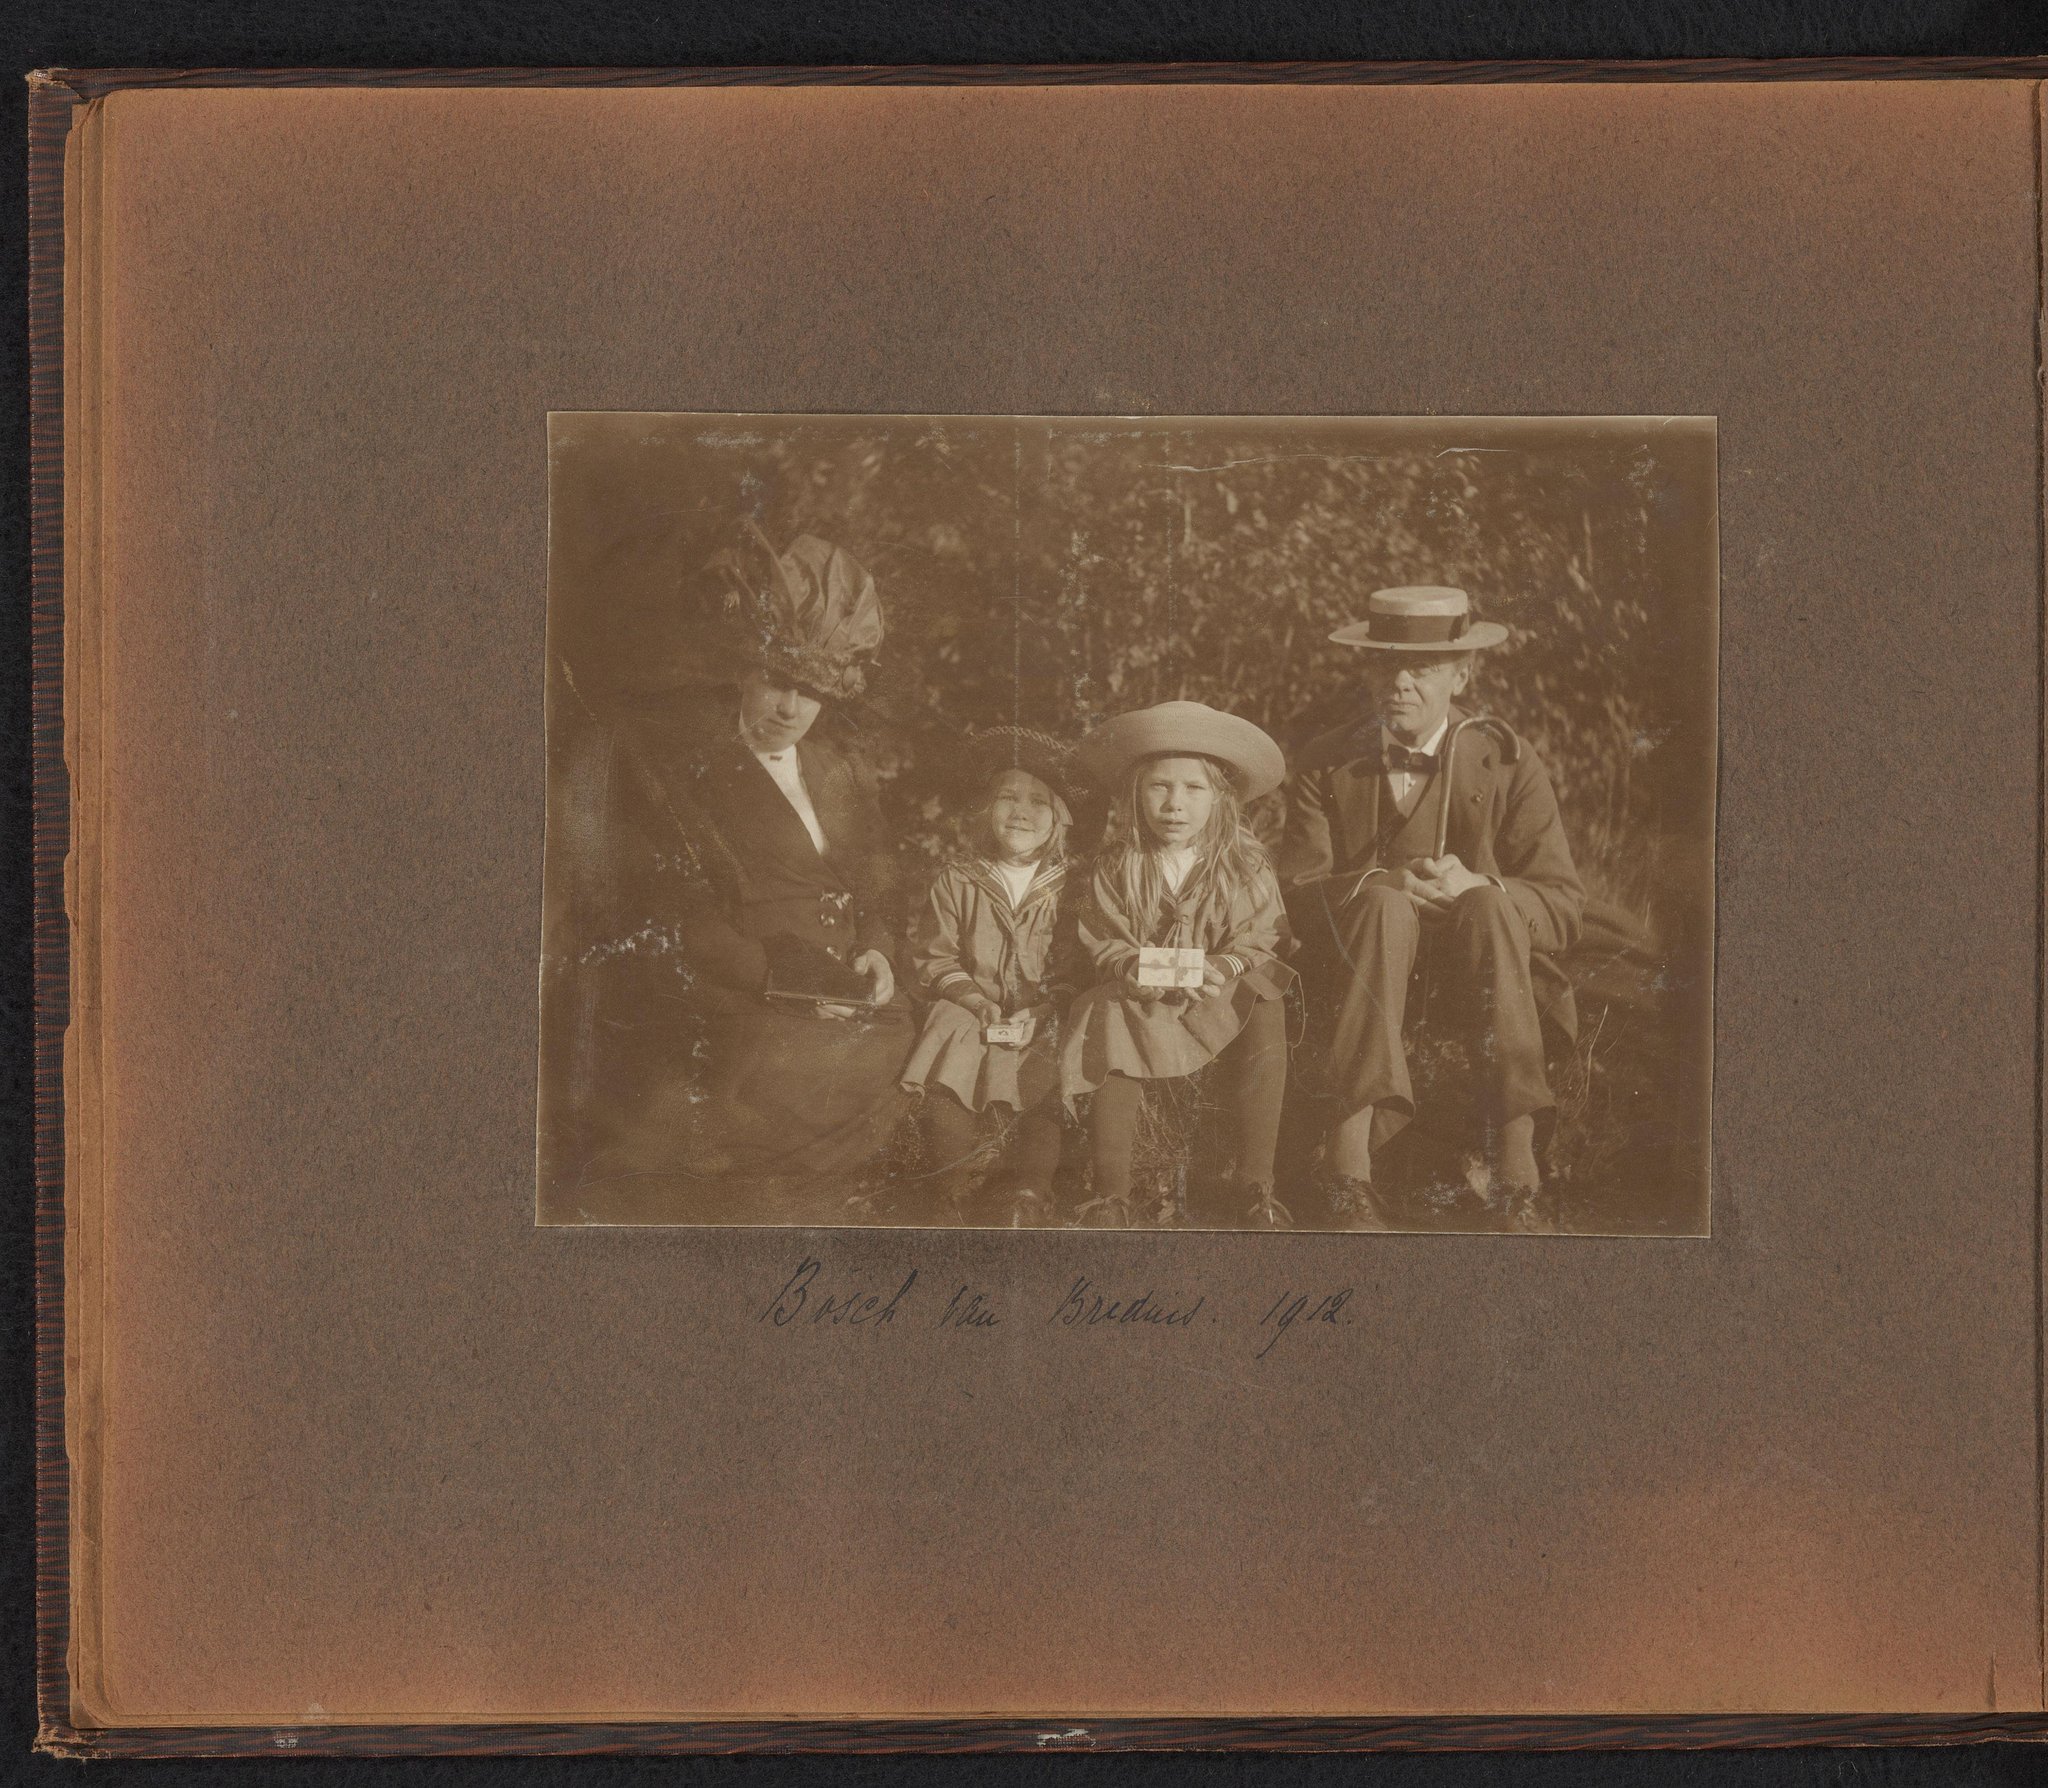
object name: album leaf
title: Bladzijde uit het fotoalbum van de familie Diepenbrock met foto van de familie Diepenbrock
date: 1912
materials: cardboard, photographic support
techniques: photography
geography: amsterdam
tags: amsterdam, alphons diepenbrock, jonkvrouw wilhelmina elisabeth petronella cornelia de jong van beek en donk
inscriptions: inscription: ‘Bosch van Bredius. 1912.’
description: Bruin albumblad 4 van familiealbum van Alphons Diepenbrock.